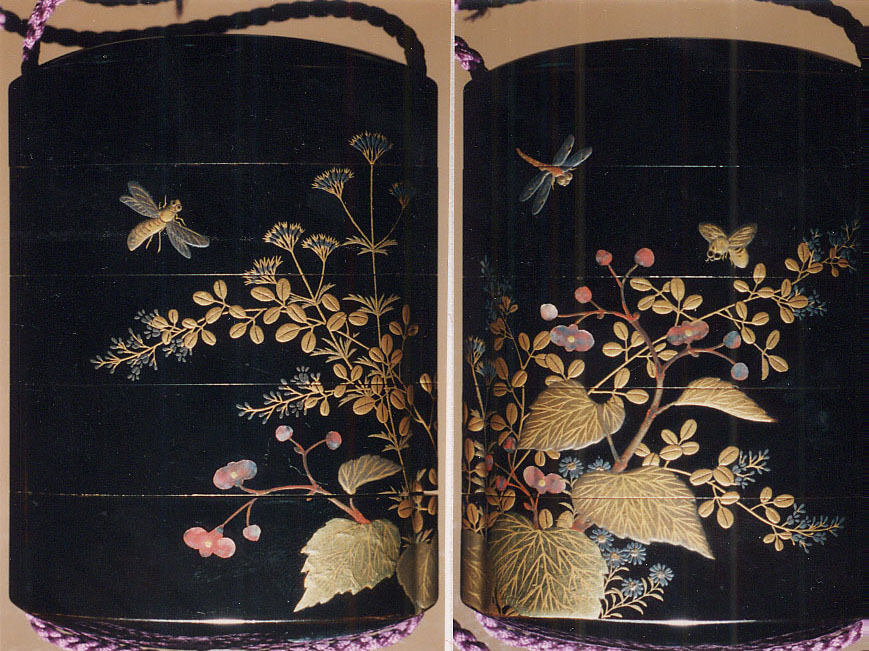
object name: inrō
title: Case (Inrō) with Design of Wildflowers, Dragonflies and Bees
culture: japanese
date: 1801-1900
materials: gold, lacquer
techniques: fundame, hiramakie, roiro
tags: bees,dragonflies,flowers